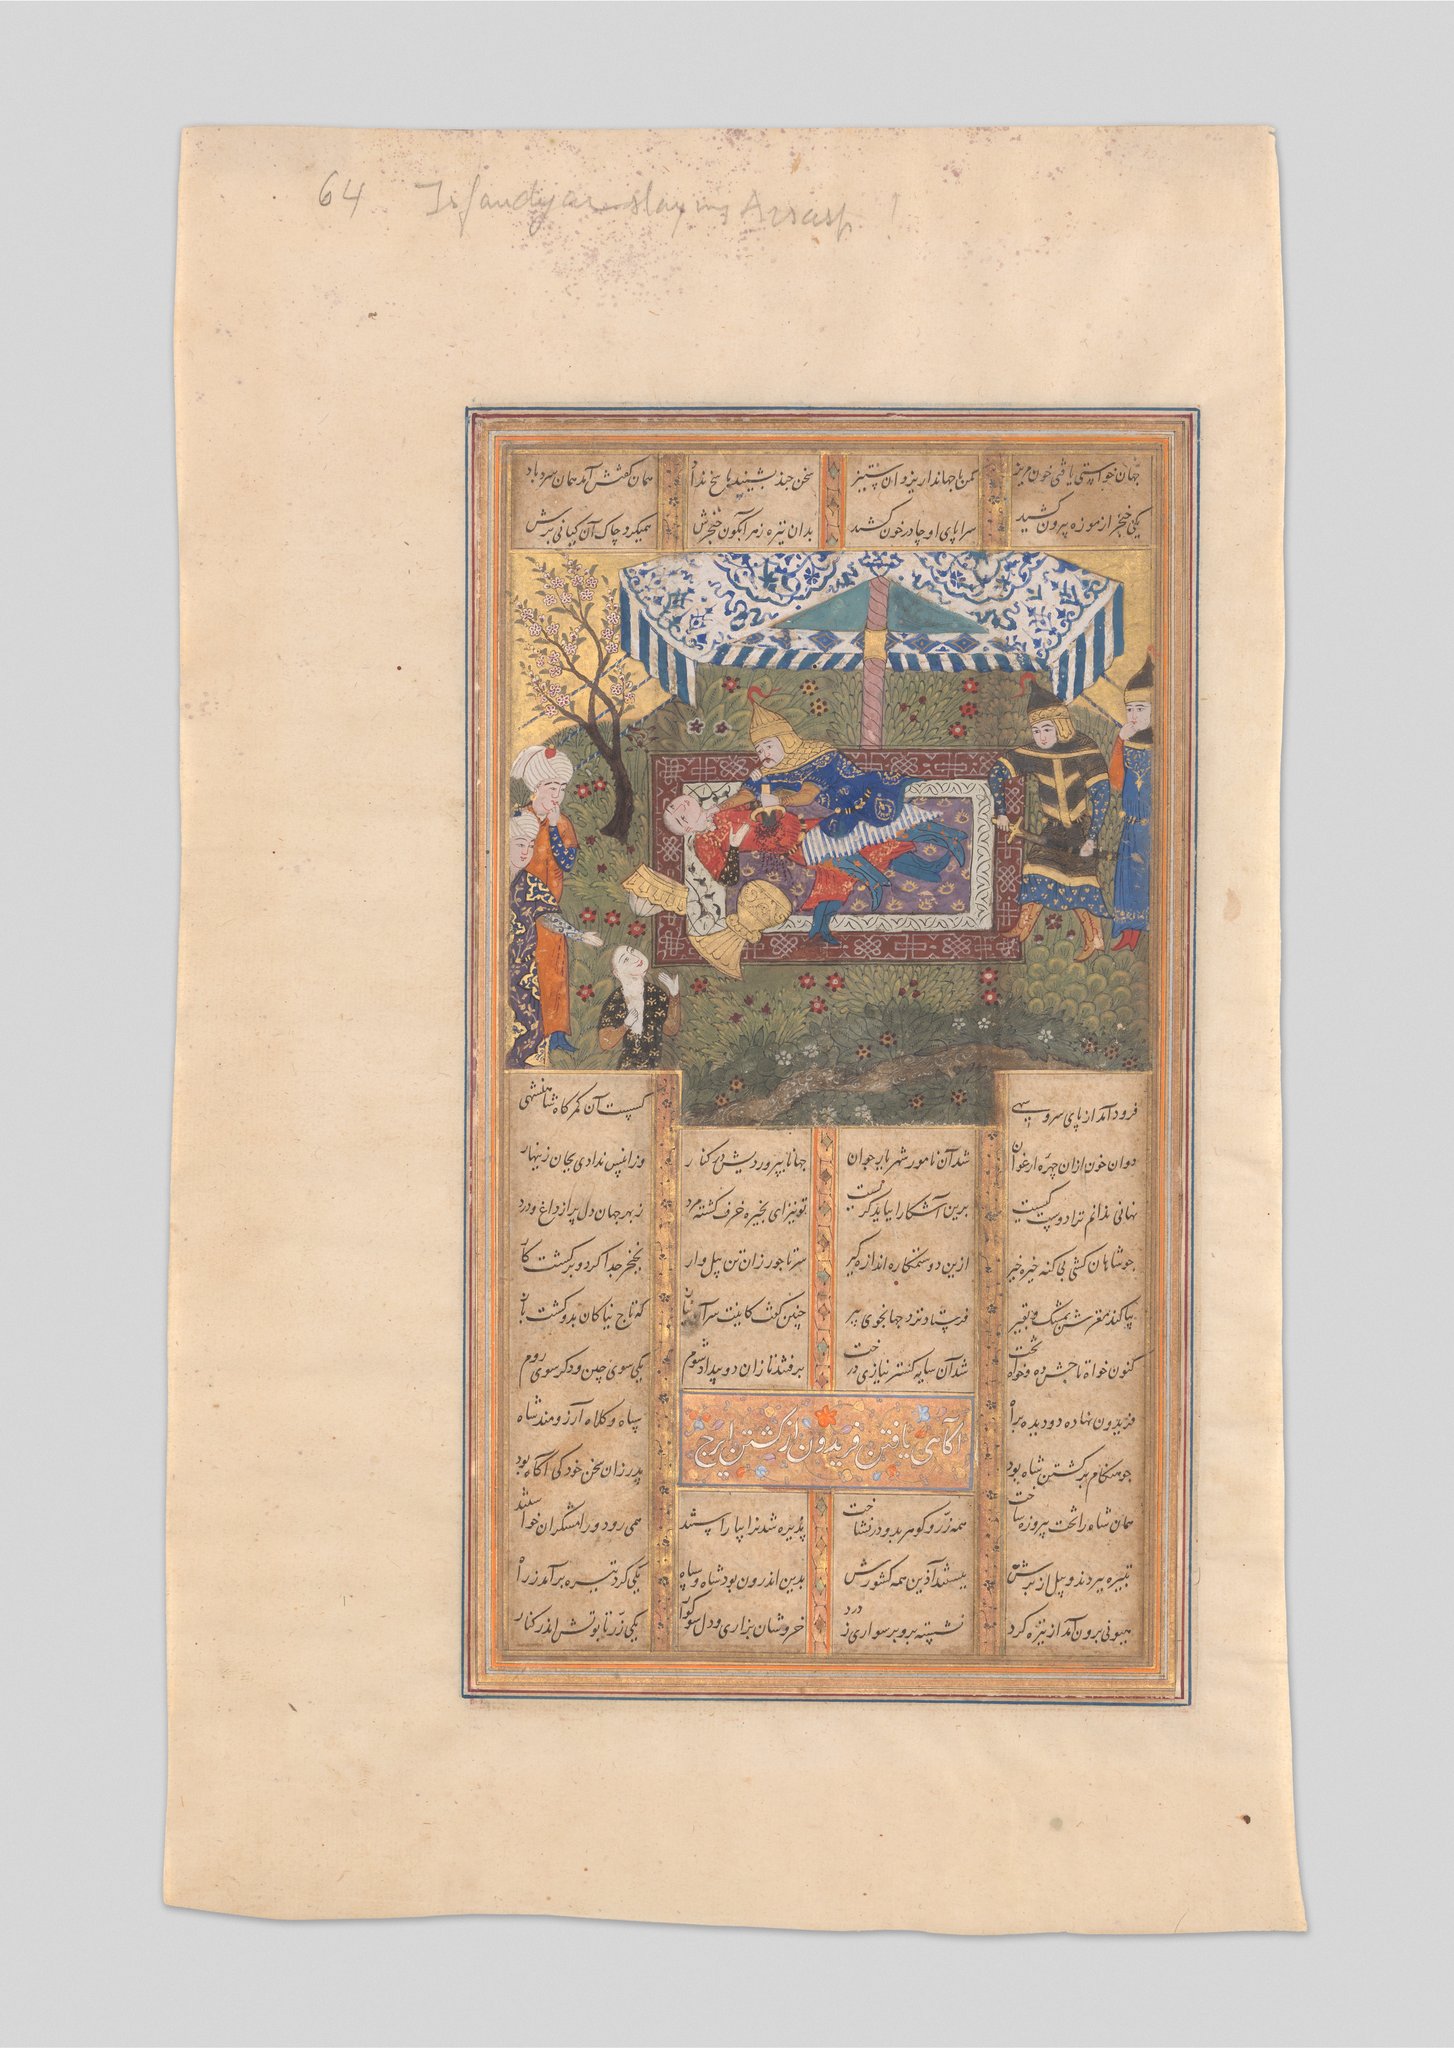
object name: folio from an illustrated manuscript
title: "The Murder of Iraj," Folio from a Shahnama (Book of Kings) of Firdausi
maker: abu'l qasim firdausi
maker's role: author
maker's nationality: iranian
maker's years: 935-1020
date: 1467-1500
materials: gold, ink, paper, watercolor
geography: iran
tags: poetry,men,death